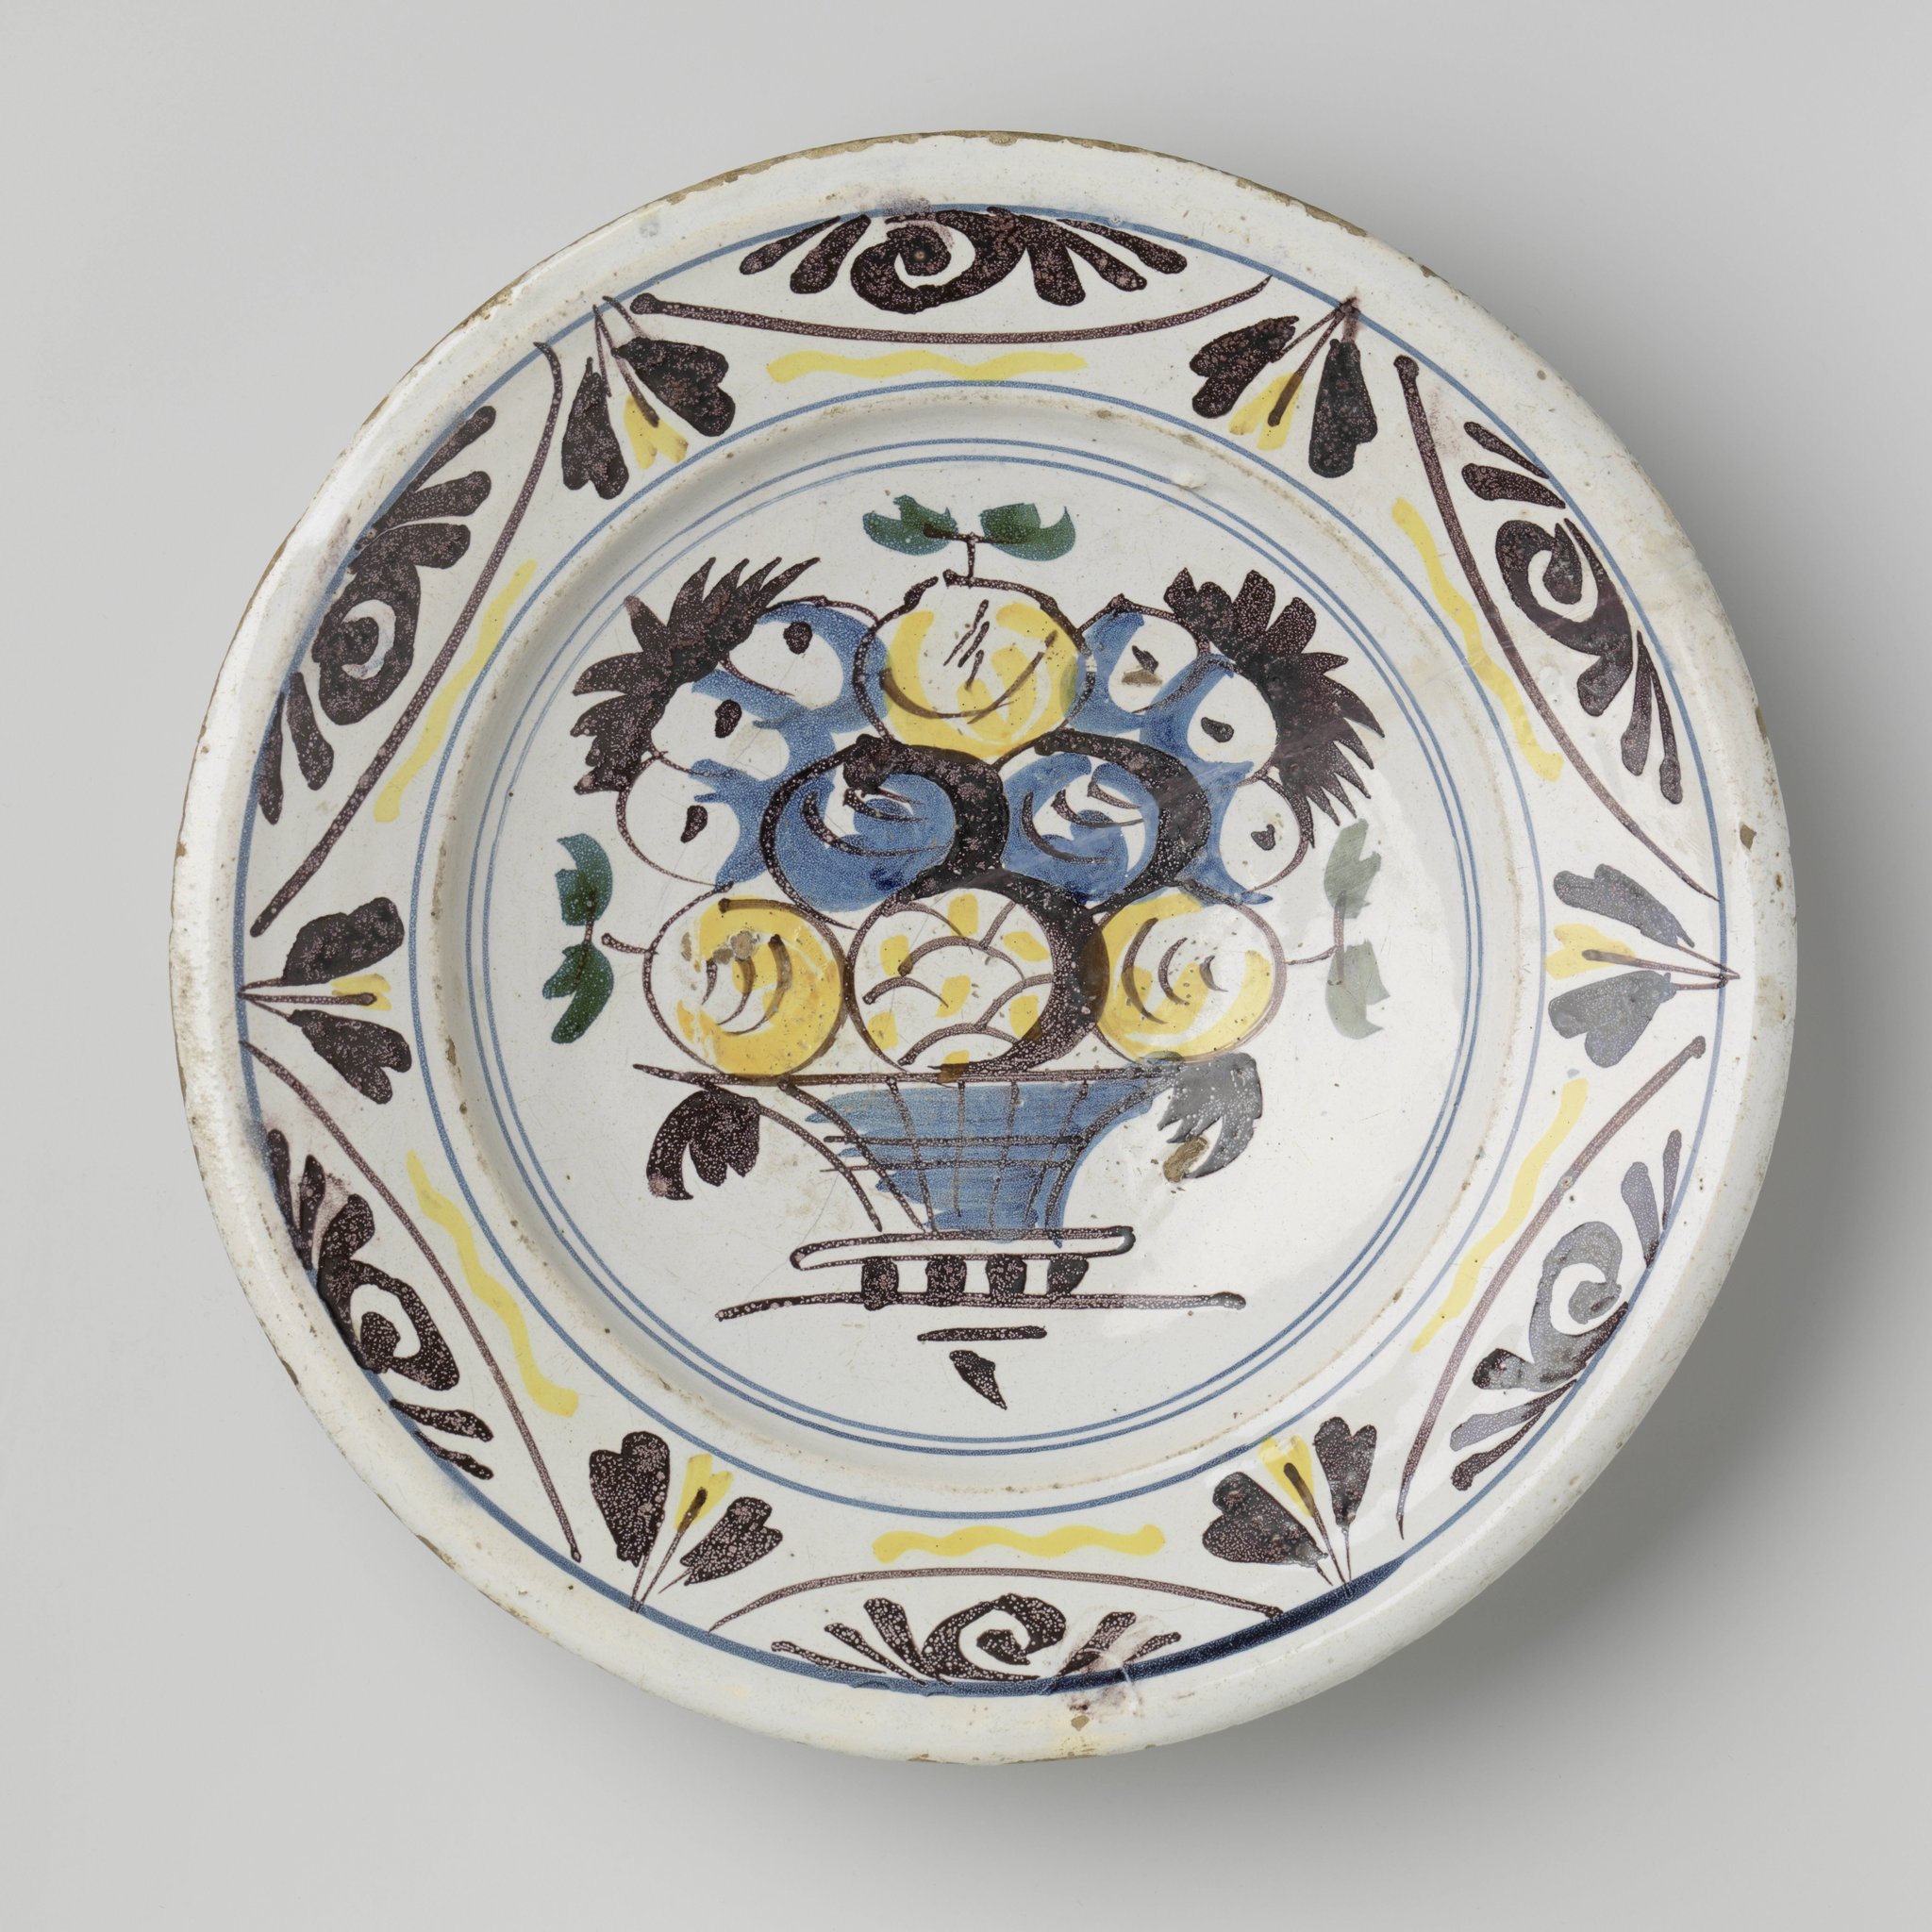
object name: platter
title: Schotel van veelkleurige majolica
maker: Anonymous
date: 1730-1780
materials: earthenware, glaze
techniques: maiolica, painted, polychromy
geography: delft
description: Ronde schotel van veelkleurig beschilderde majolica. Op het plat is een mand met vruchten geschilderd waar omheen concentrische cirkels. Op de rand zijn zes segmentbogen geschilderd met palmetten en gestileerde bladeren.